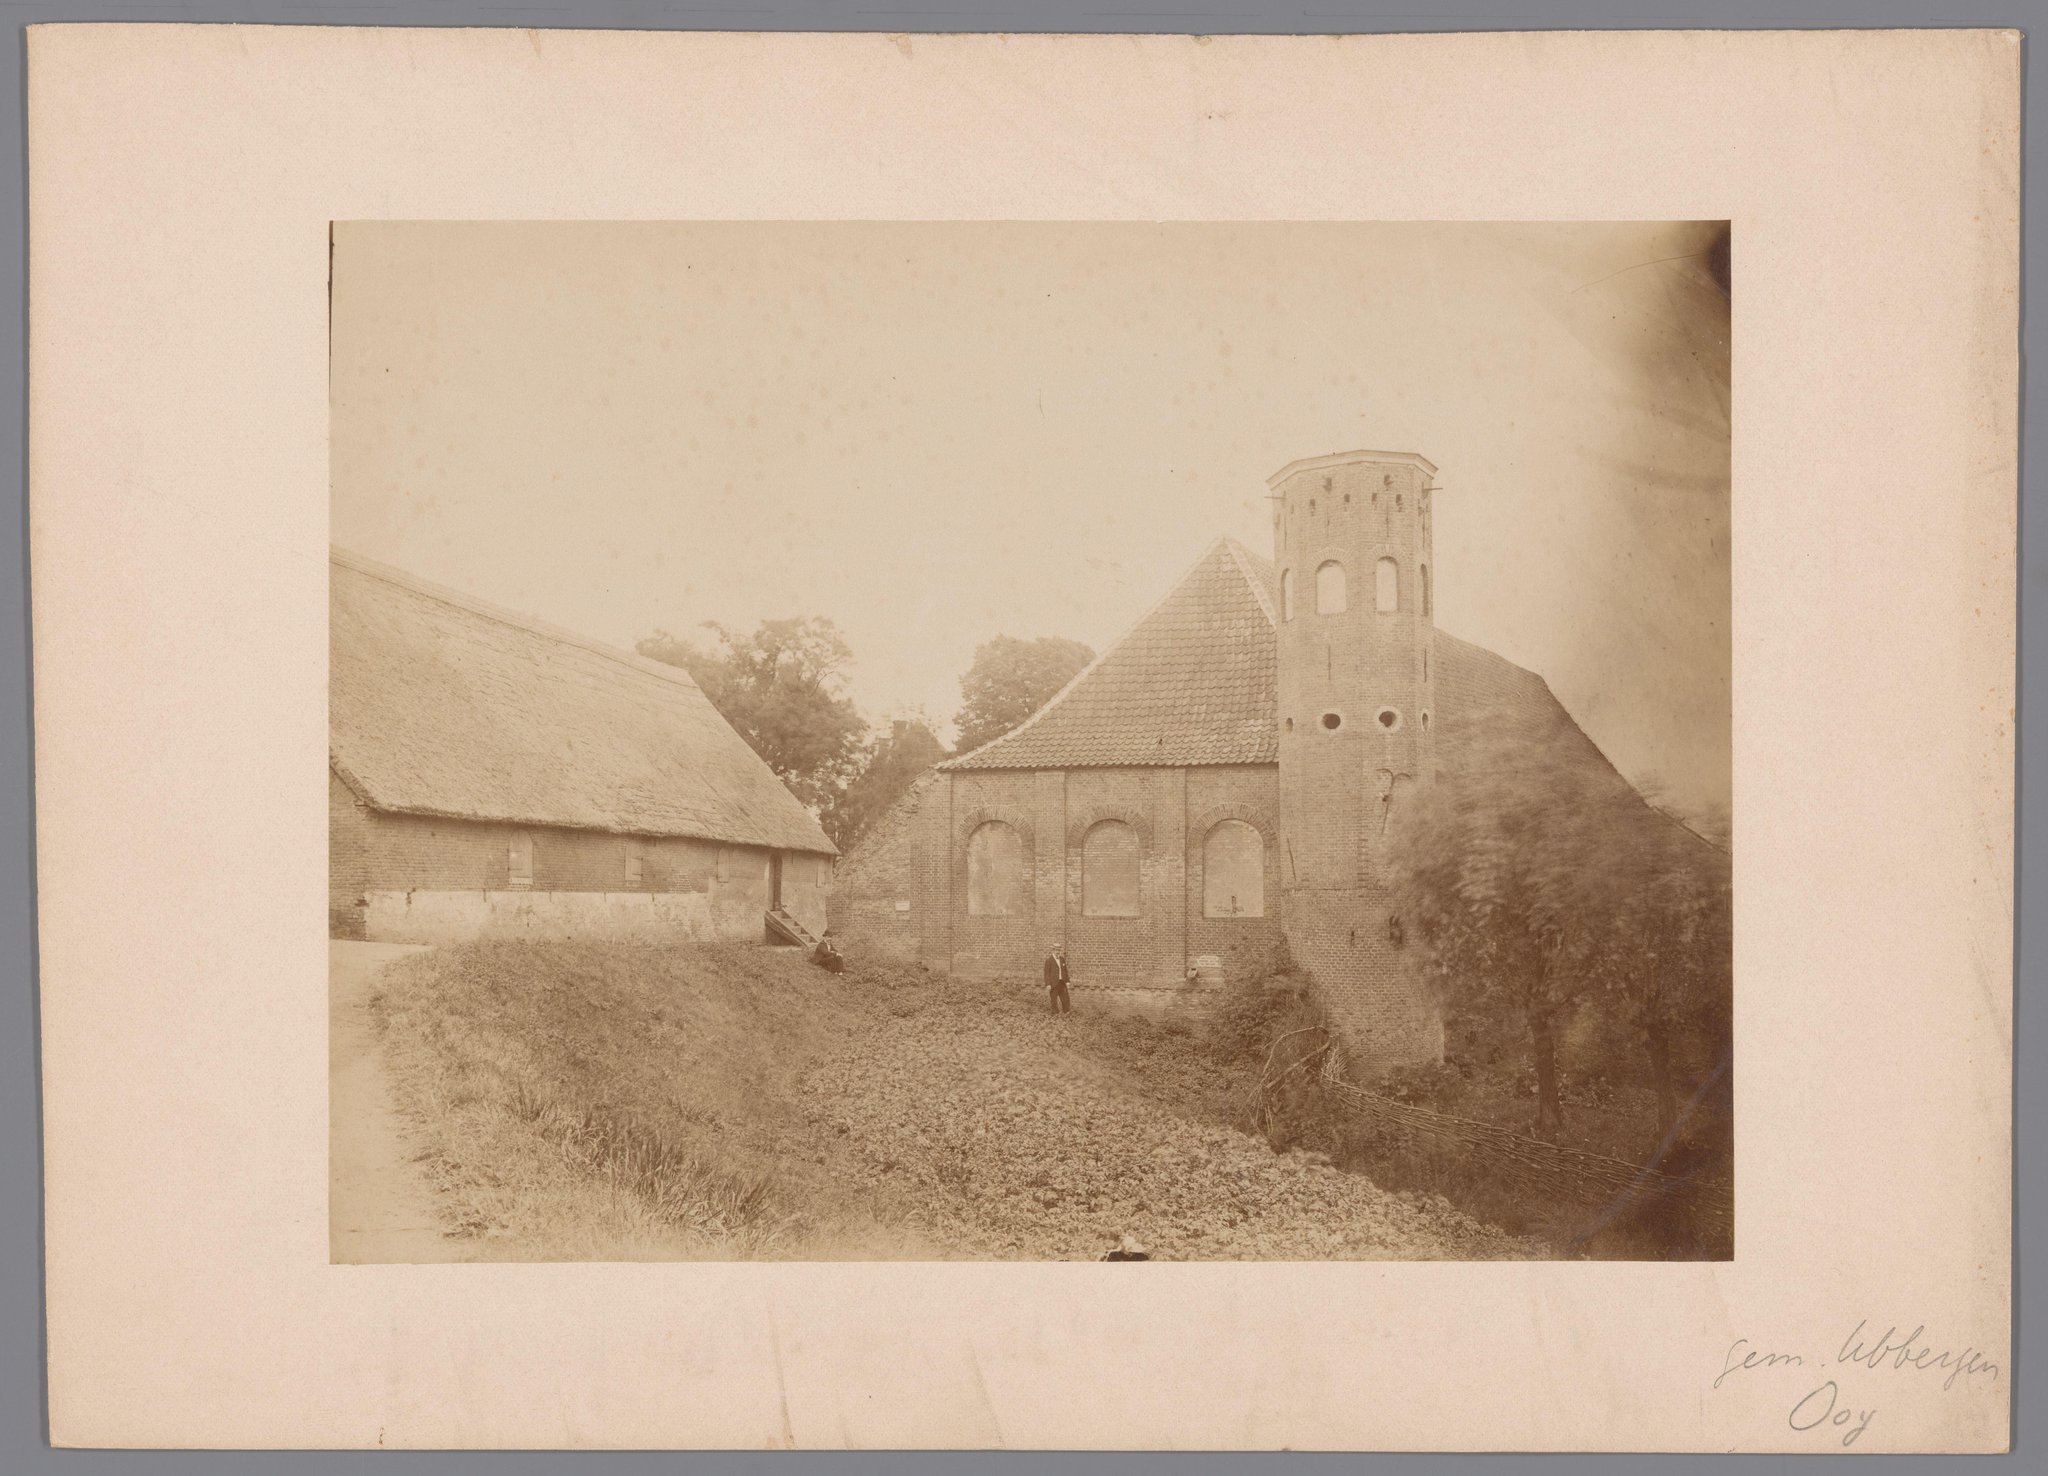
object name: photograph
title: Zijgevel van de stalling van Kasteel van Ooy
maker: anoniem (monumentenzorg)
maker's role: fotograaf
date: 1899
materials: cardboard, photographic support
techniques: albumen print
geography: ubbergen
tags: stall, stable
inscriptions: annotation: ‘gem. Ubbergen/ Ooy’, annotation: ‘Zijgevel der stalling behoordende bij het voormalige kasteel te Ooy bij Nijmegen (G.)/ juni 1899’